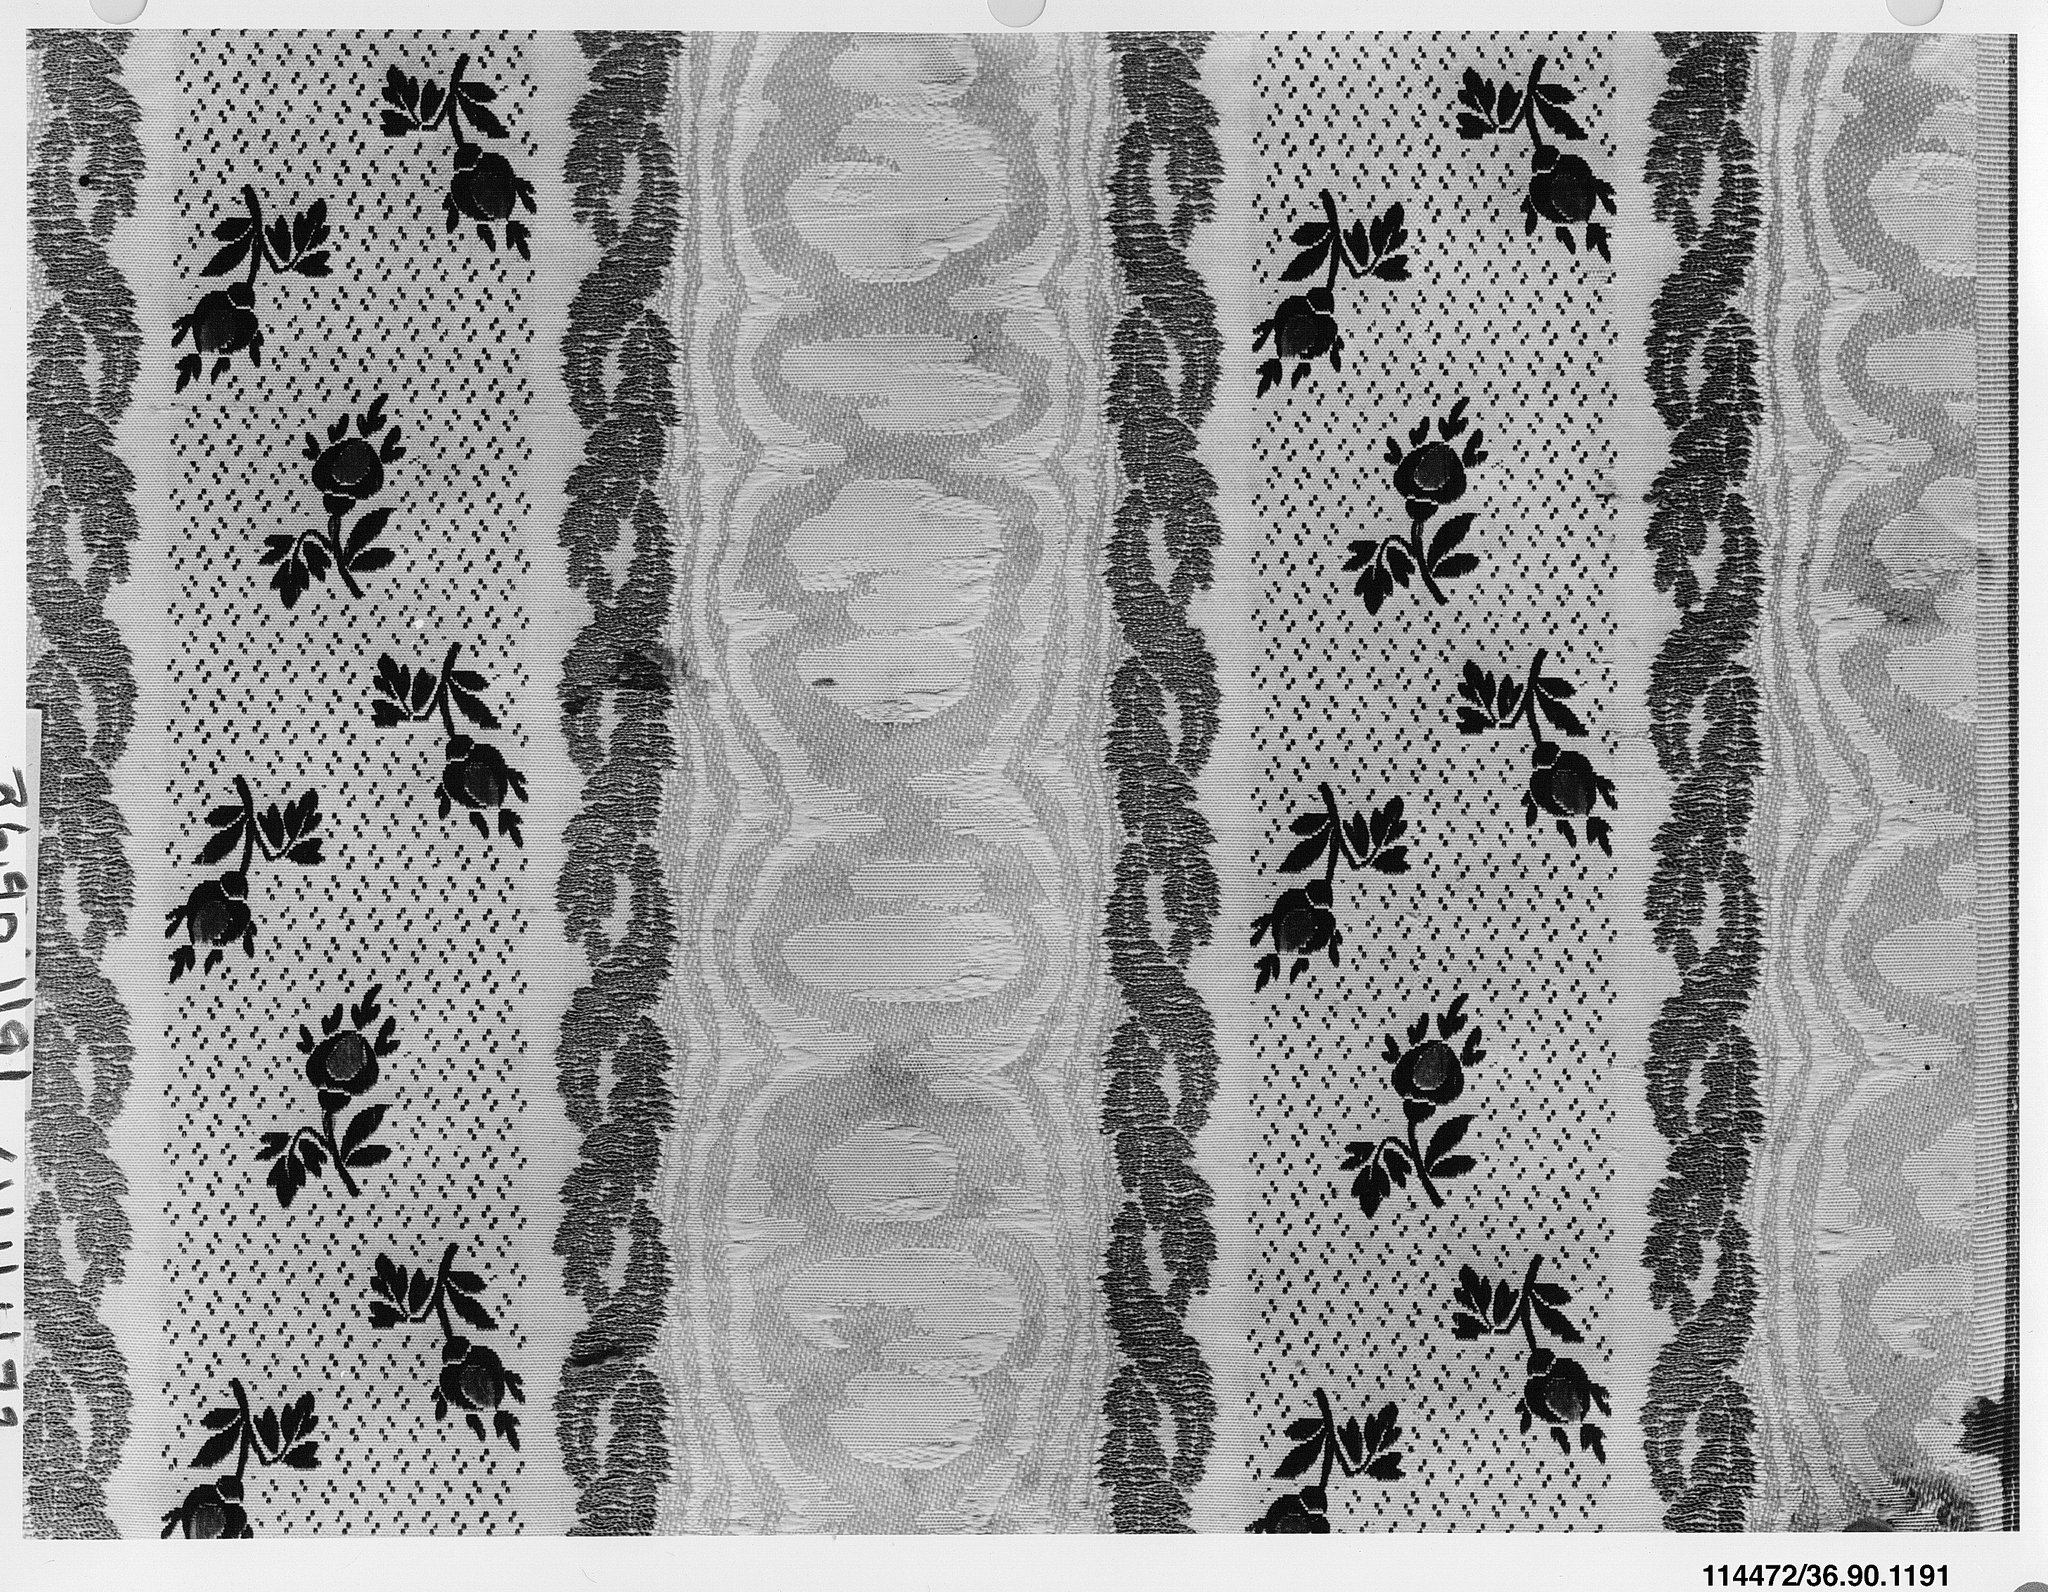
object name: piece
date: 1801-1900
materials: metal thread, silk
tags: flowers,leaves